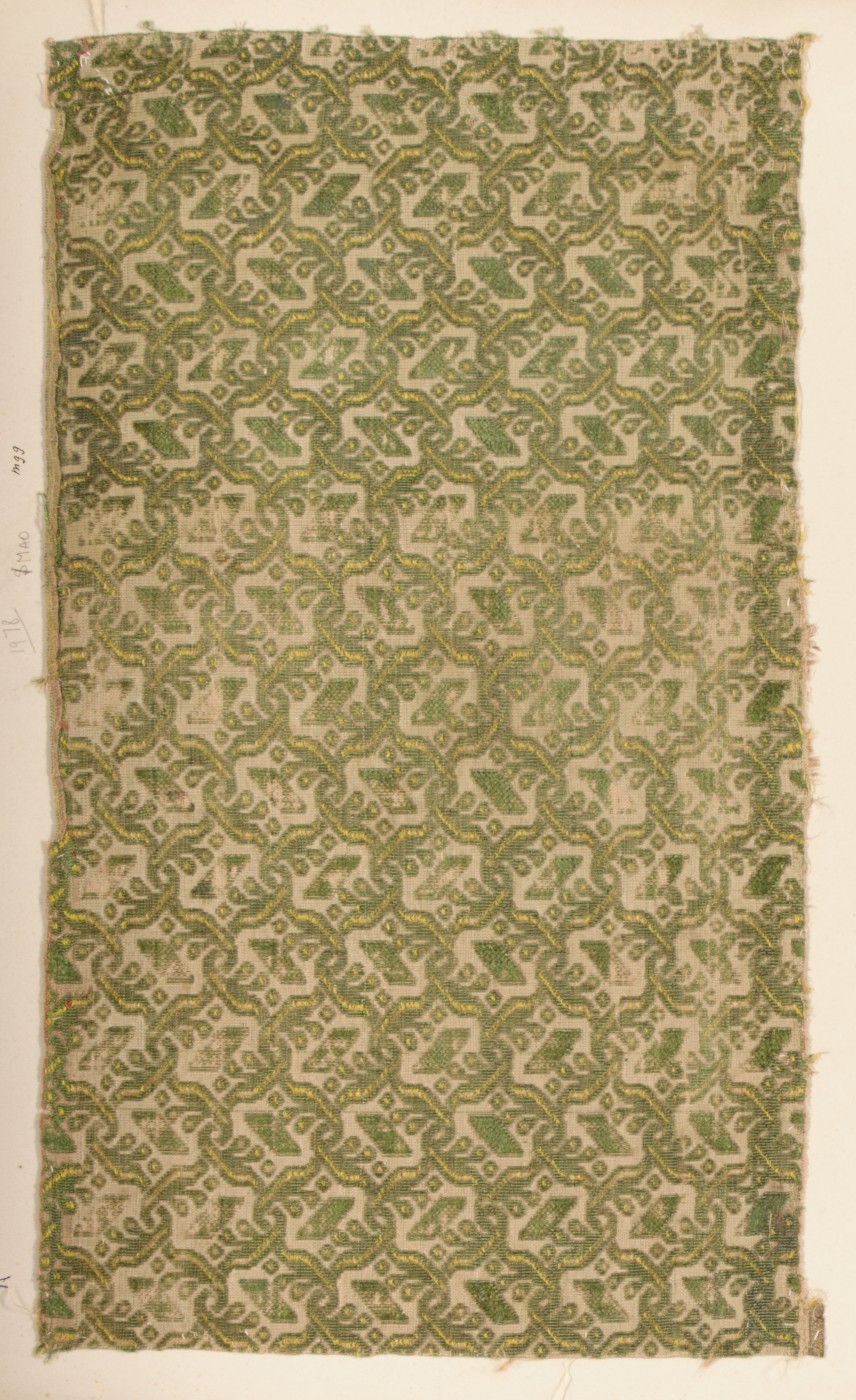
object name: fragment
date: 1501-1600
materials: silk